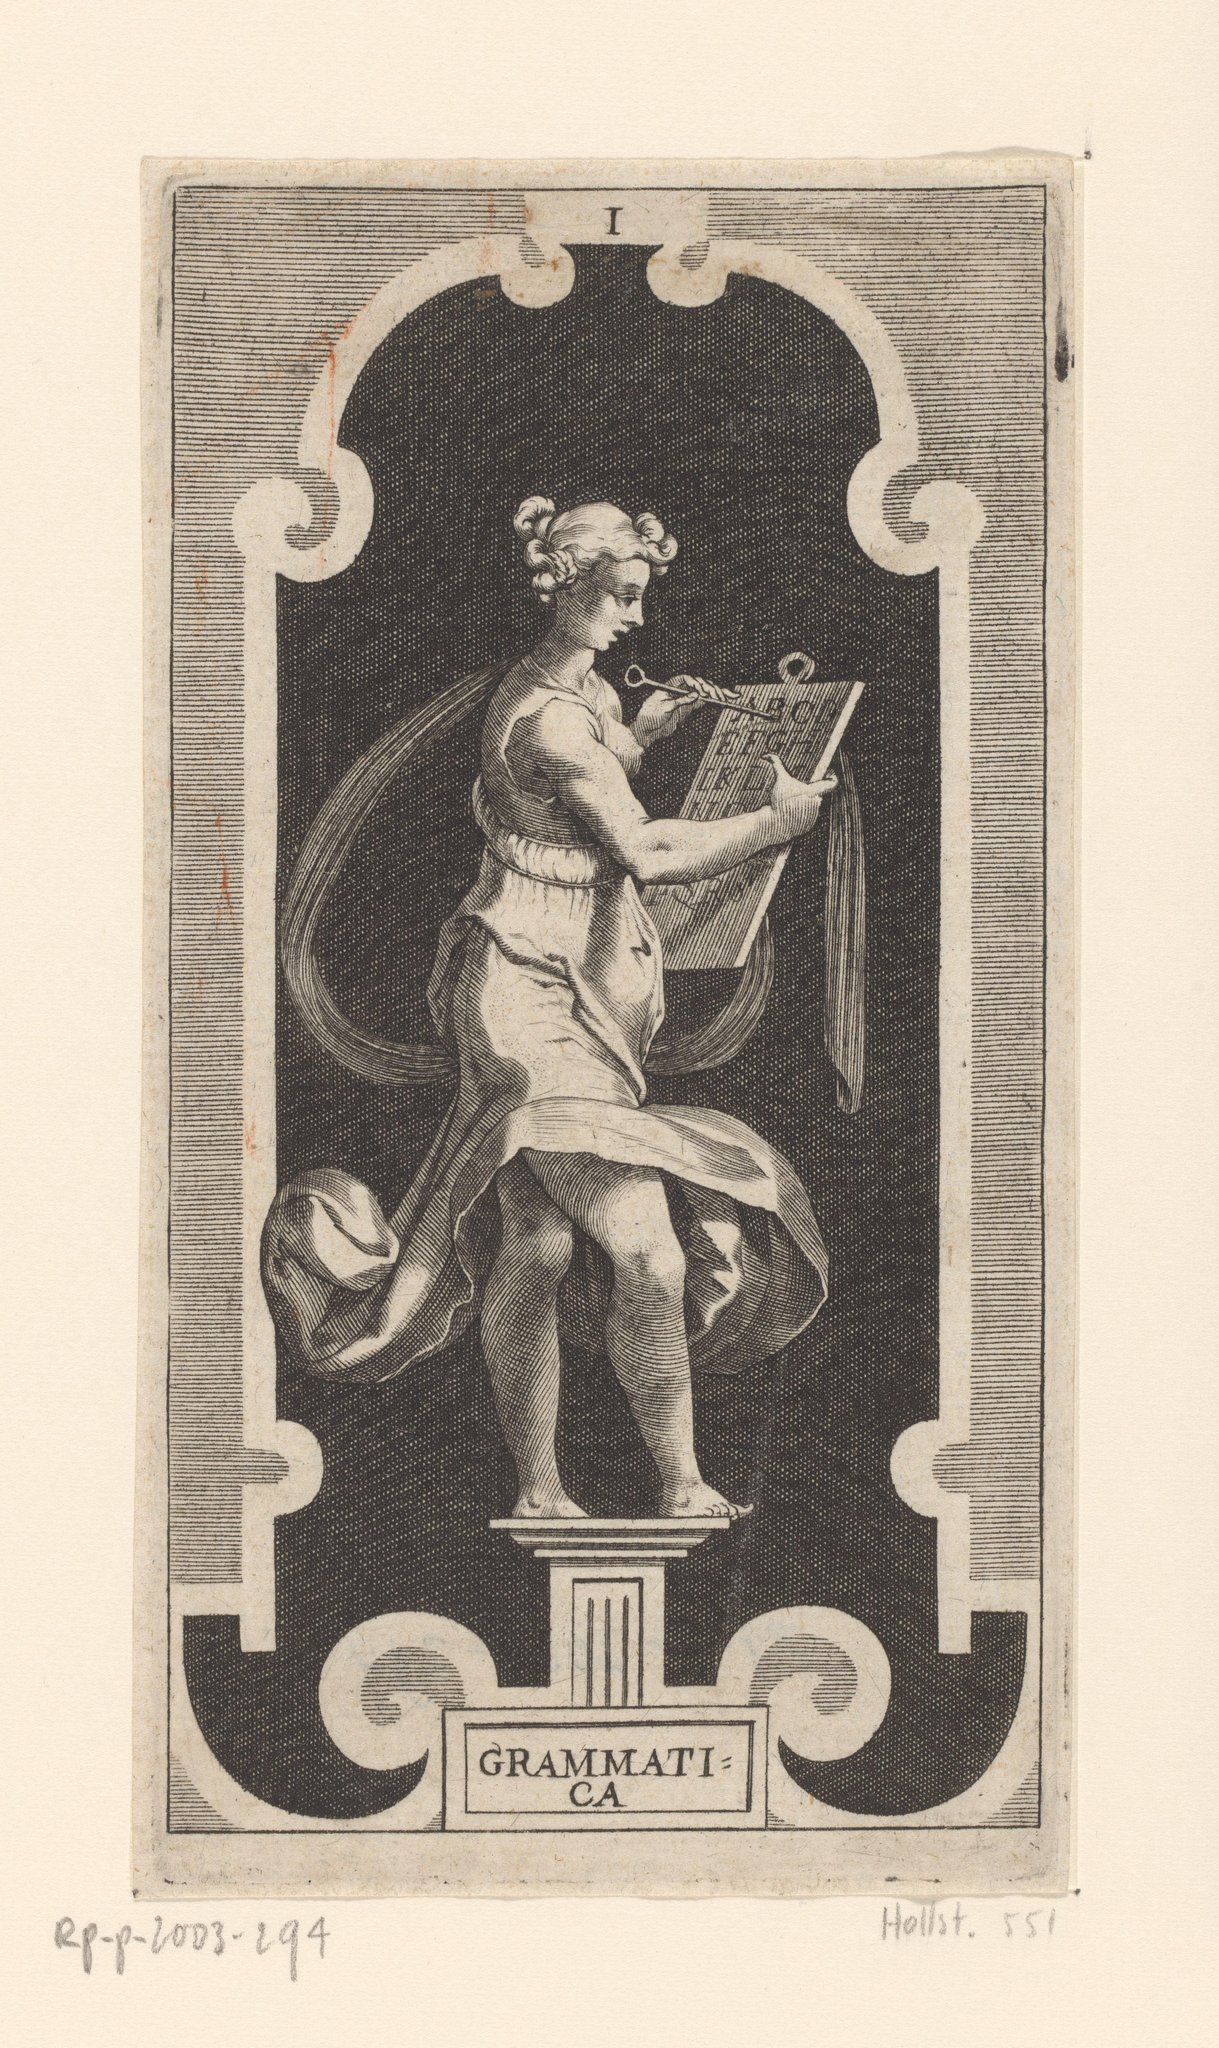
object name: print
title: Septem Artium Liberalium icones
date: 1640-1708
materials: paper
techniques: engraving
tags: the liberal arts, 'artes liberales', letters, alphabet, script, 'grammatica' (~ trivium); 'grammatica' (ripa)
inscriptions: collector's mark: Lugt 2760, collector's mark: Lugt 2228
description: Deze prent hoort bij een serie van zeven prenten met personificaties van Zeven Vrij Kunsten.